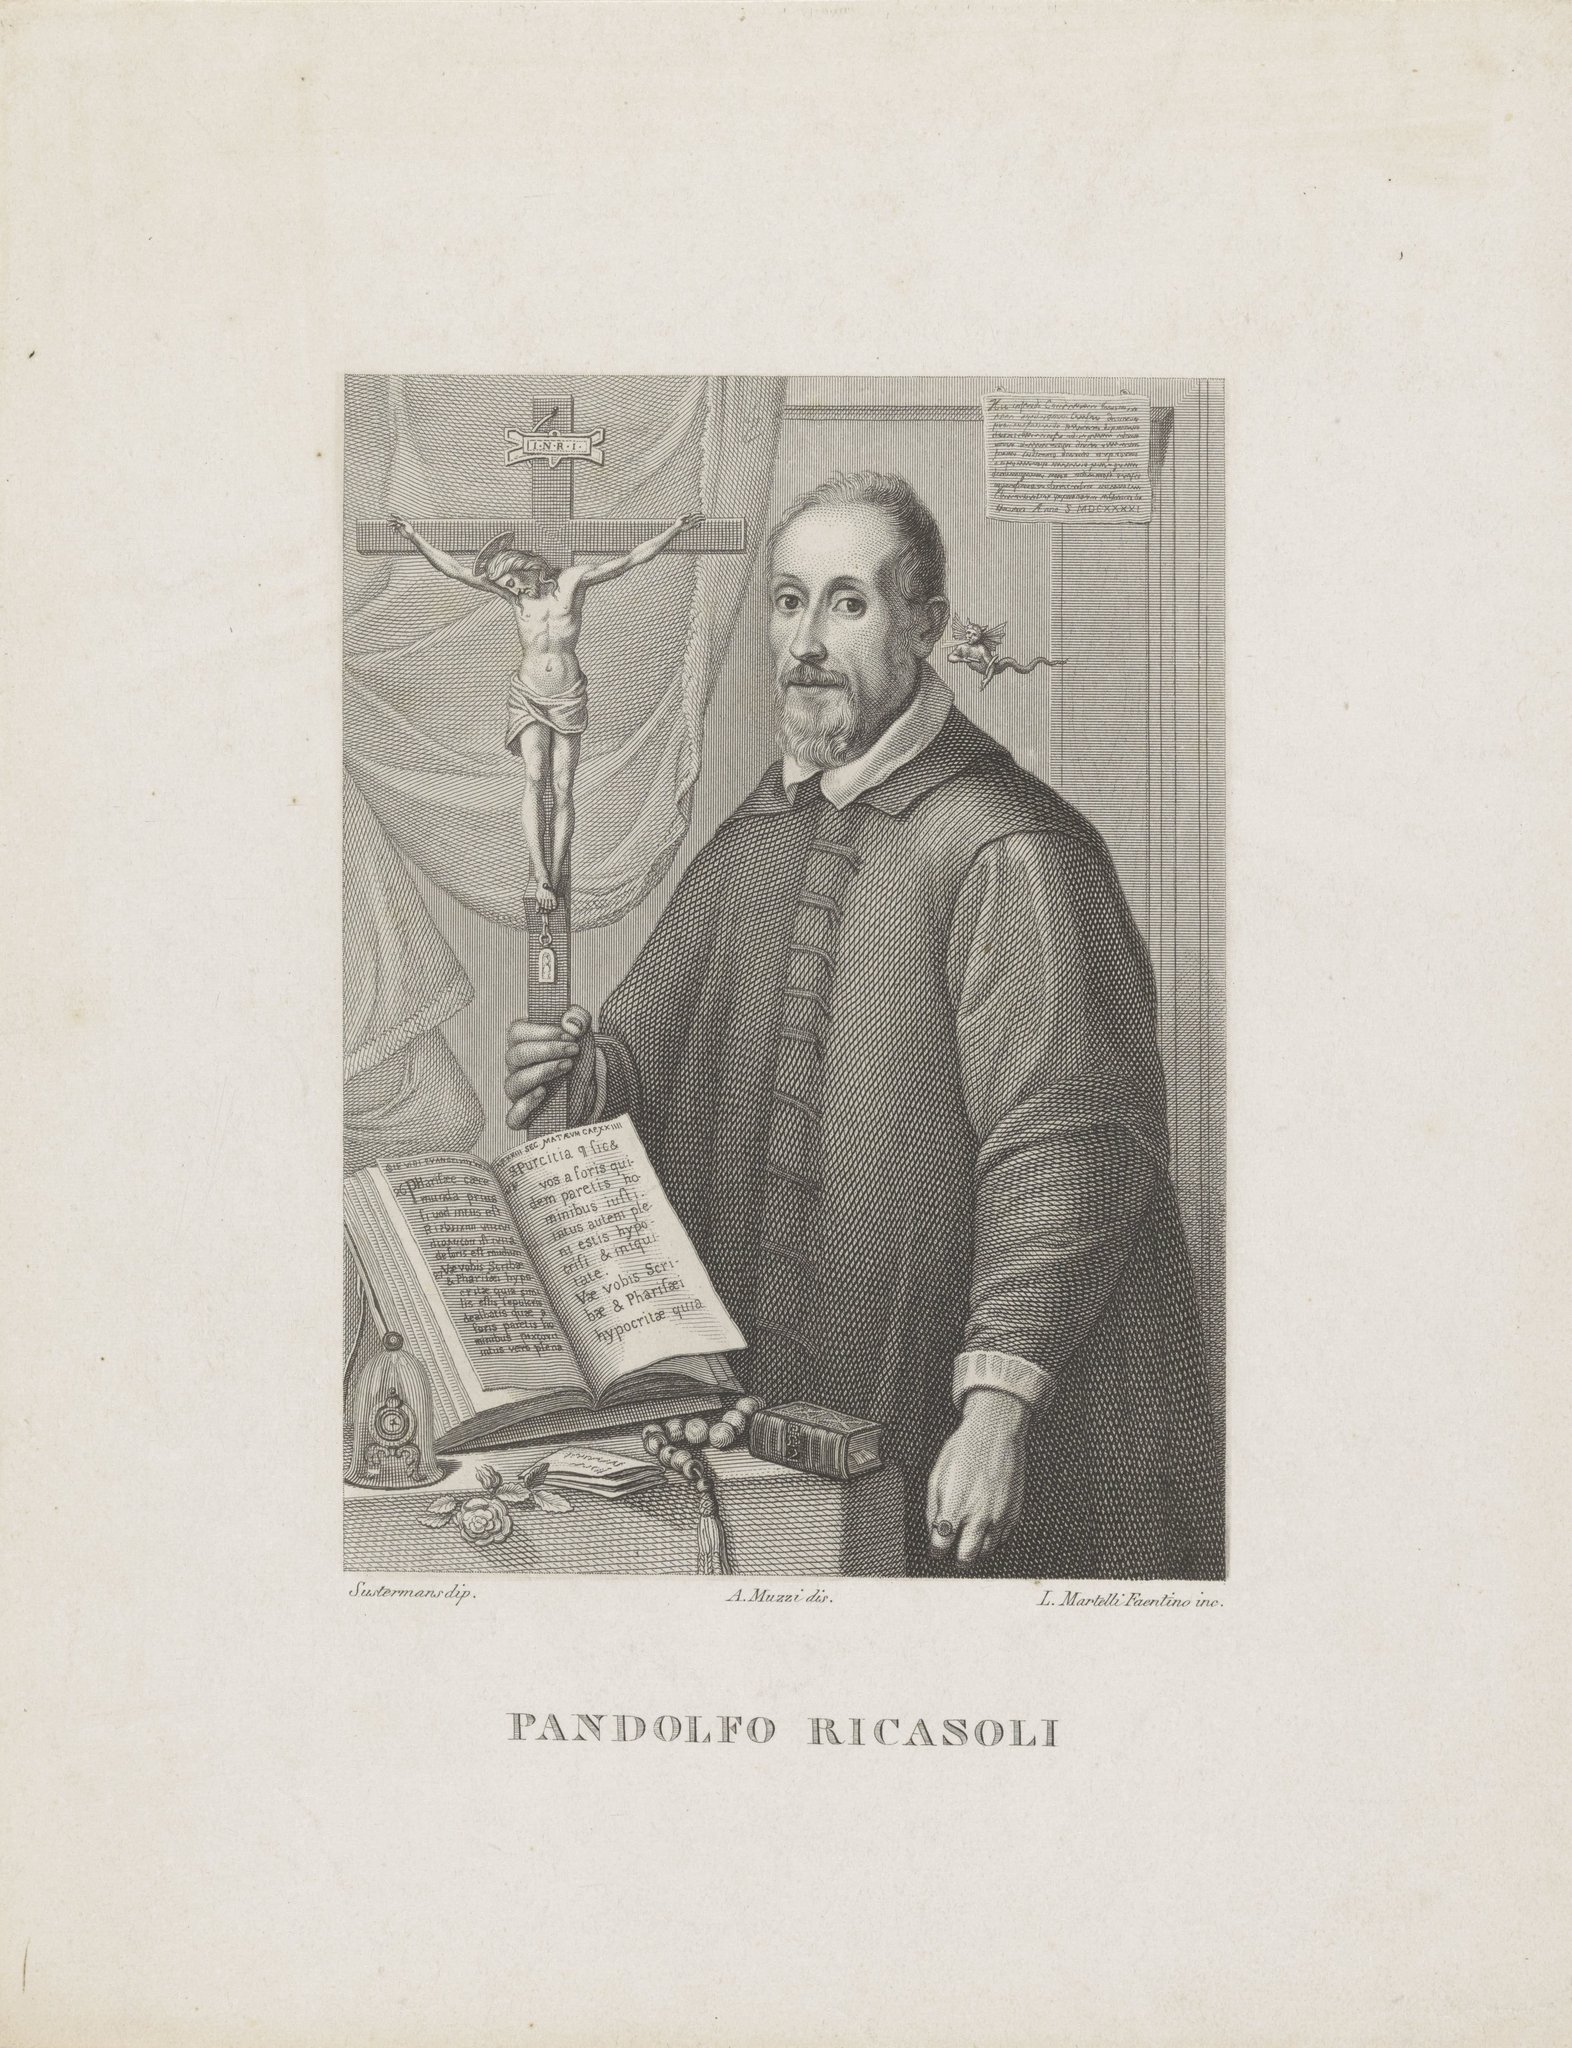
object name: print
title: Portret van geestelijke Pandolfo Ricasoli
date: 1814-1853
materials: paper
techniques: engraving, etching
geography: florence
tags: historical persons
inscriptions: collector's mark: Lugt 2228